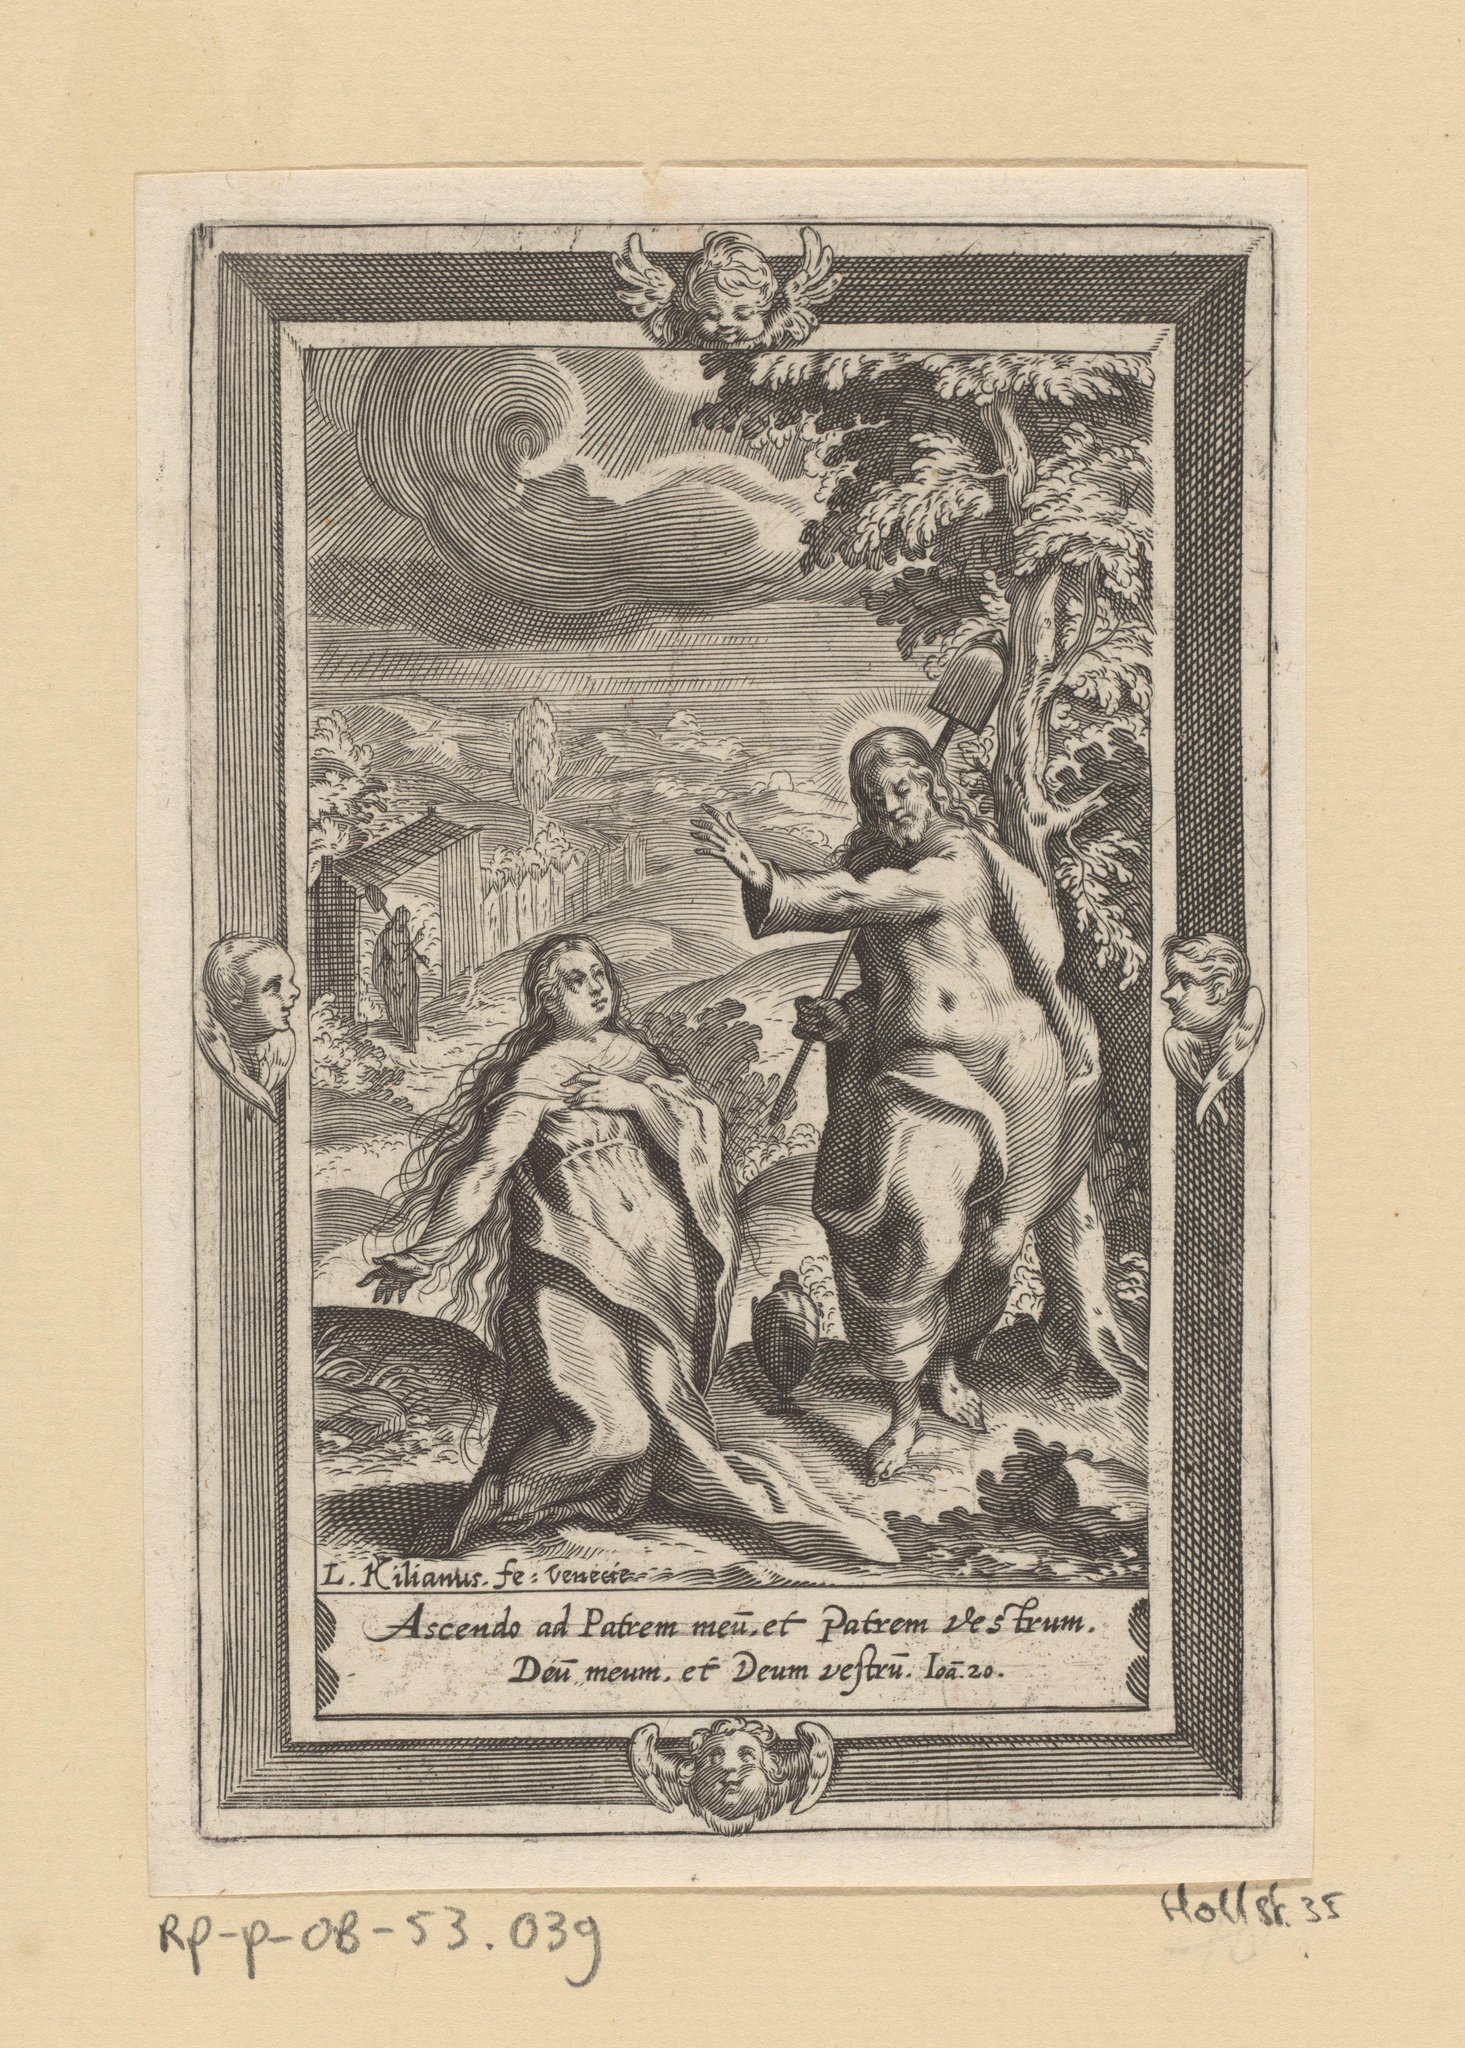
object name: print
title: Christus verschijnt als tuinman aan Maria Magdalena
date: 1589-1637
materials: paper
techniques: engraving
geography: venice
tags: mary magdalene kneeling before christ, who is usually represented as a gardener with a hoe and/or a spade; 'noli me tangere'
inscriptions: collector's mark: Lugt 240